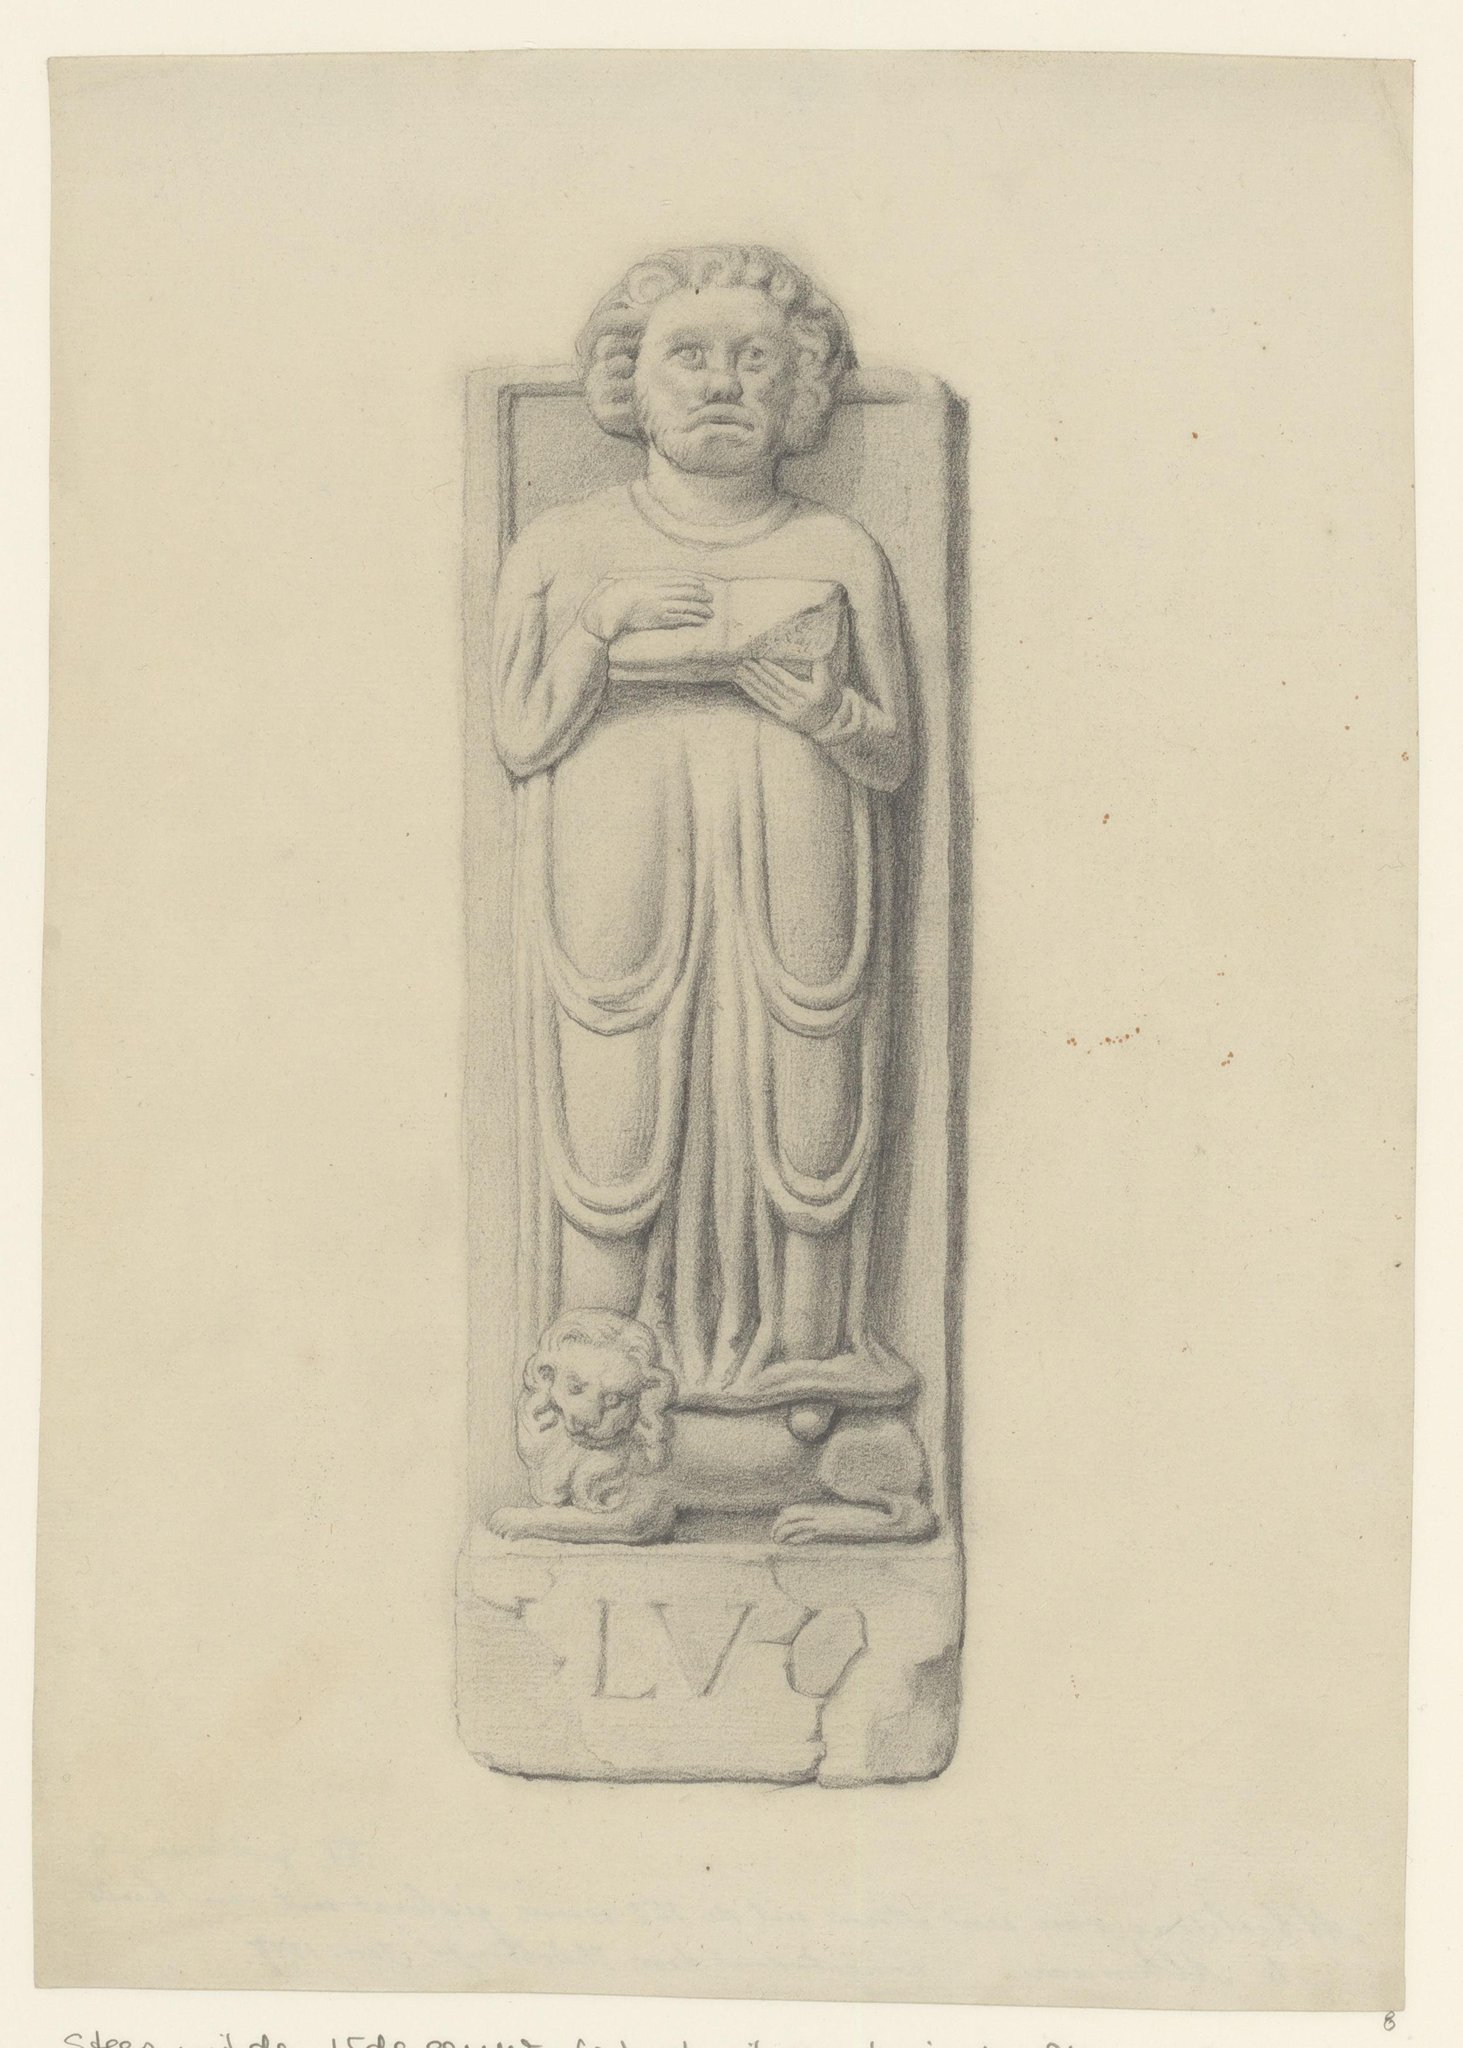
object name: drawing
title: Steen uit een huis te Alkmaar, mogelijk Marcus de evangelist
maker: Anonymous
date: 1800-1877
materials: paper, pencil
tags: stone tablet in façade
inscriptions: stamp, collector's mark: Lugt 1641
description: Steen uit een huis te Alkmaar, mogelijk Marcus de evangelist. Man staat op een leeuw eronder de letters: LVO. Mogelijk uit de Langestraat te Amsterdam. Onderwerpsrubrieken binnen de Atlas Zeden en Gewoonten: Handel, nijverheid en verkeer, Uithangteekens, gevelstenen.